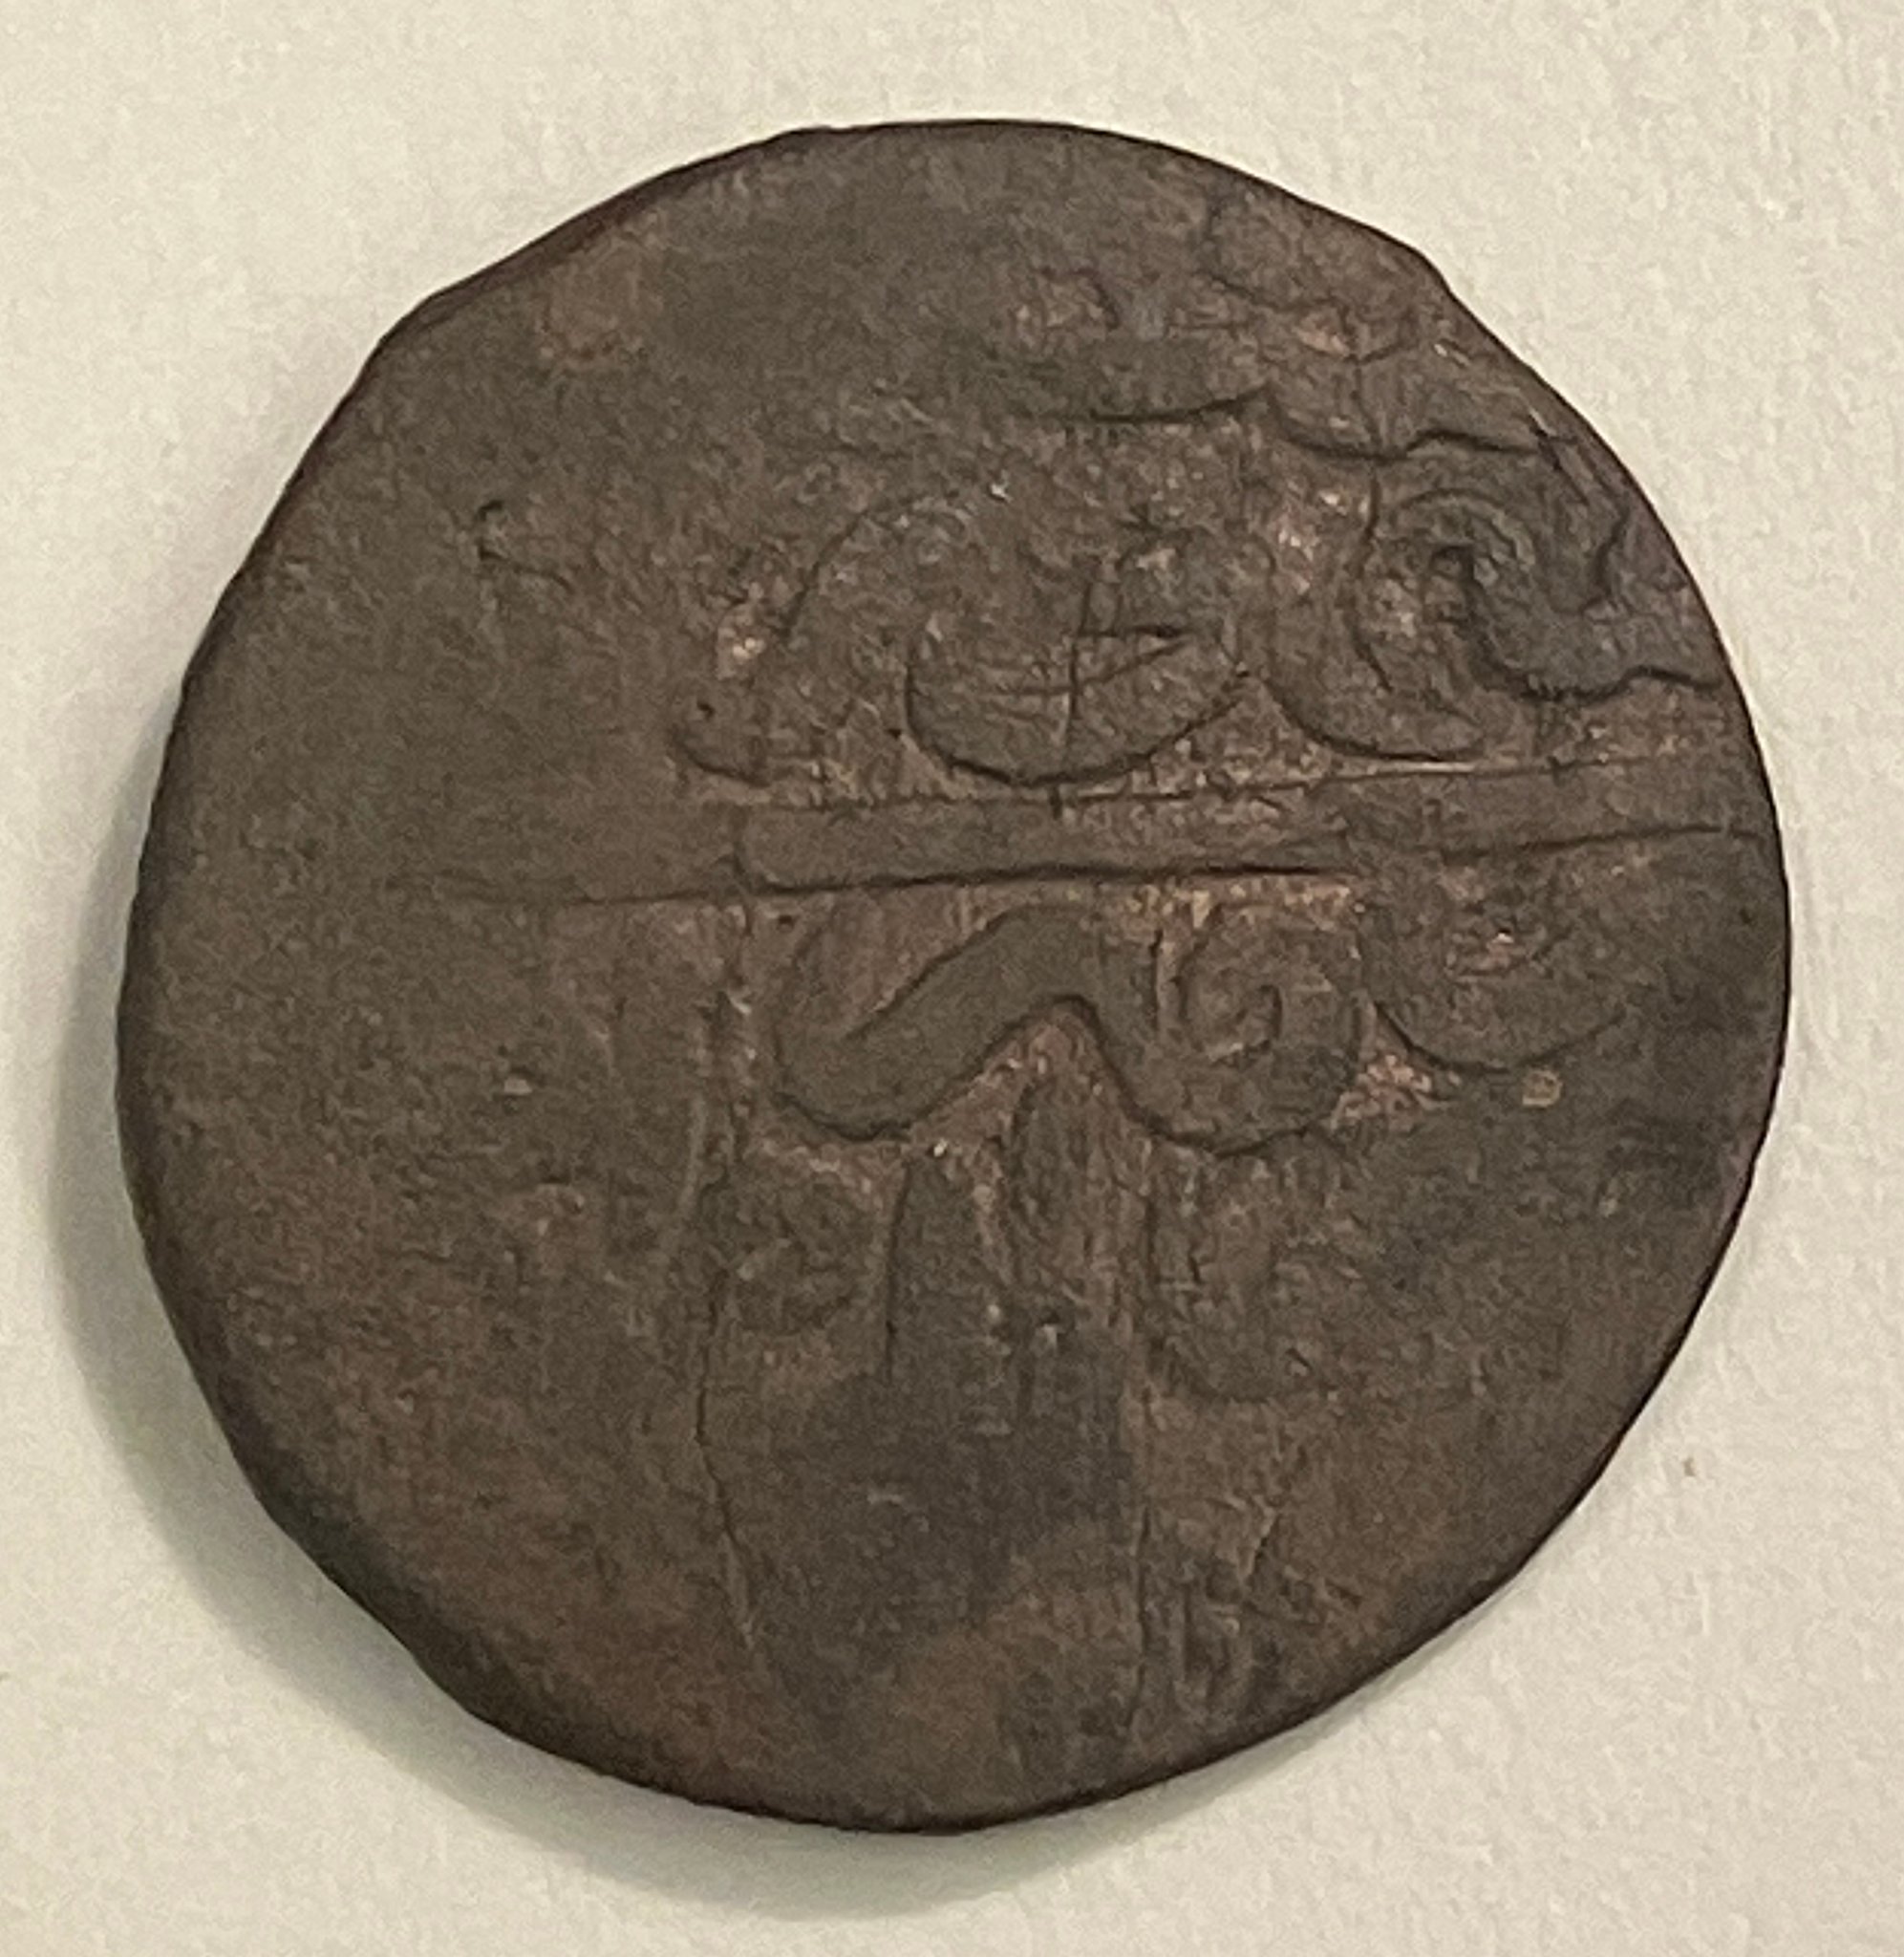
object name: coin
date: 401-1400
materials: copper, gold, silver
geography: iran